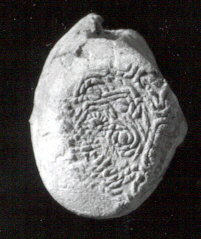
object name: sealing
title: Sealing with one circular seal impression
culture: assyrian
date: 1800-1701 BCE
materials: clay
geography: anatolia